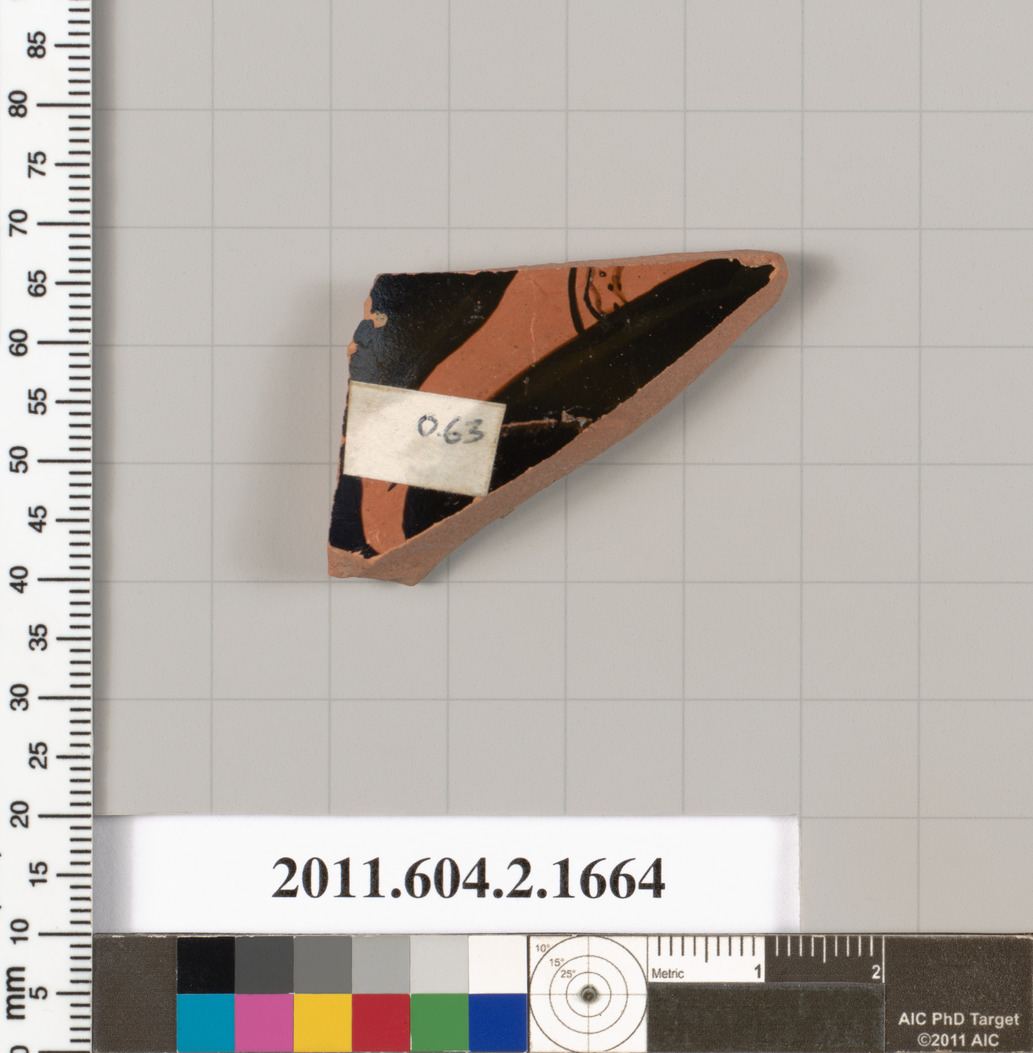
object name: skyphos fragment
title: Terracotta fragment of a skyphos (deep drinking cup)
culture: greek, attic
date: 425-401 BCE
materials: terracotta